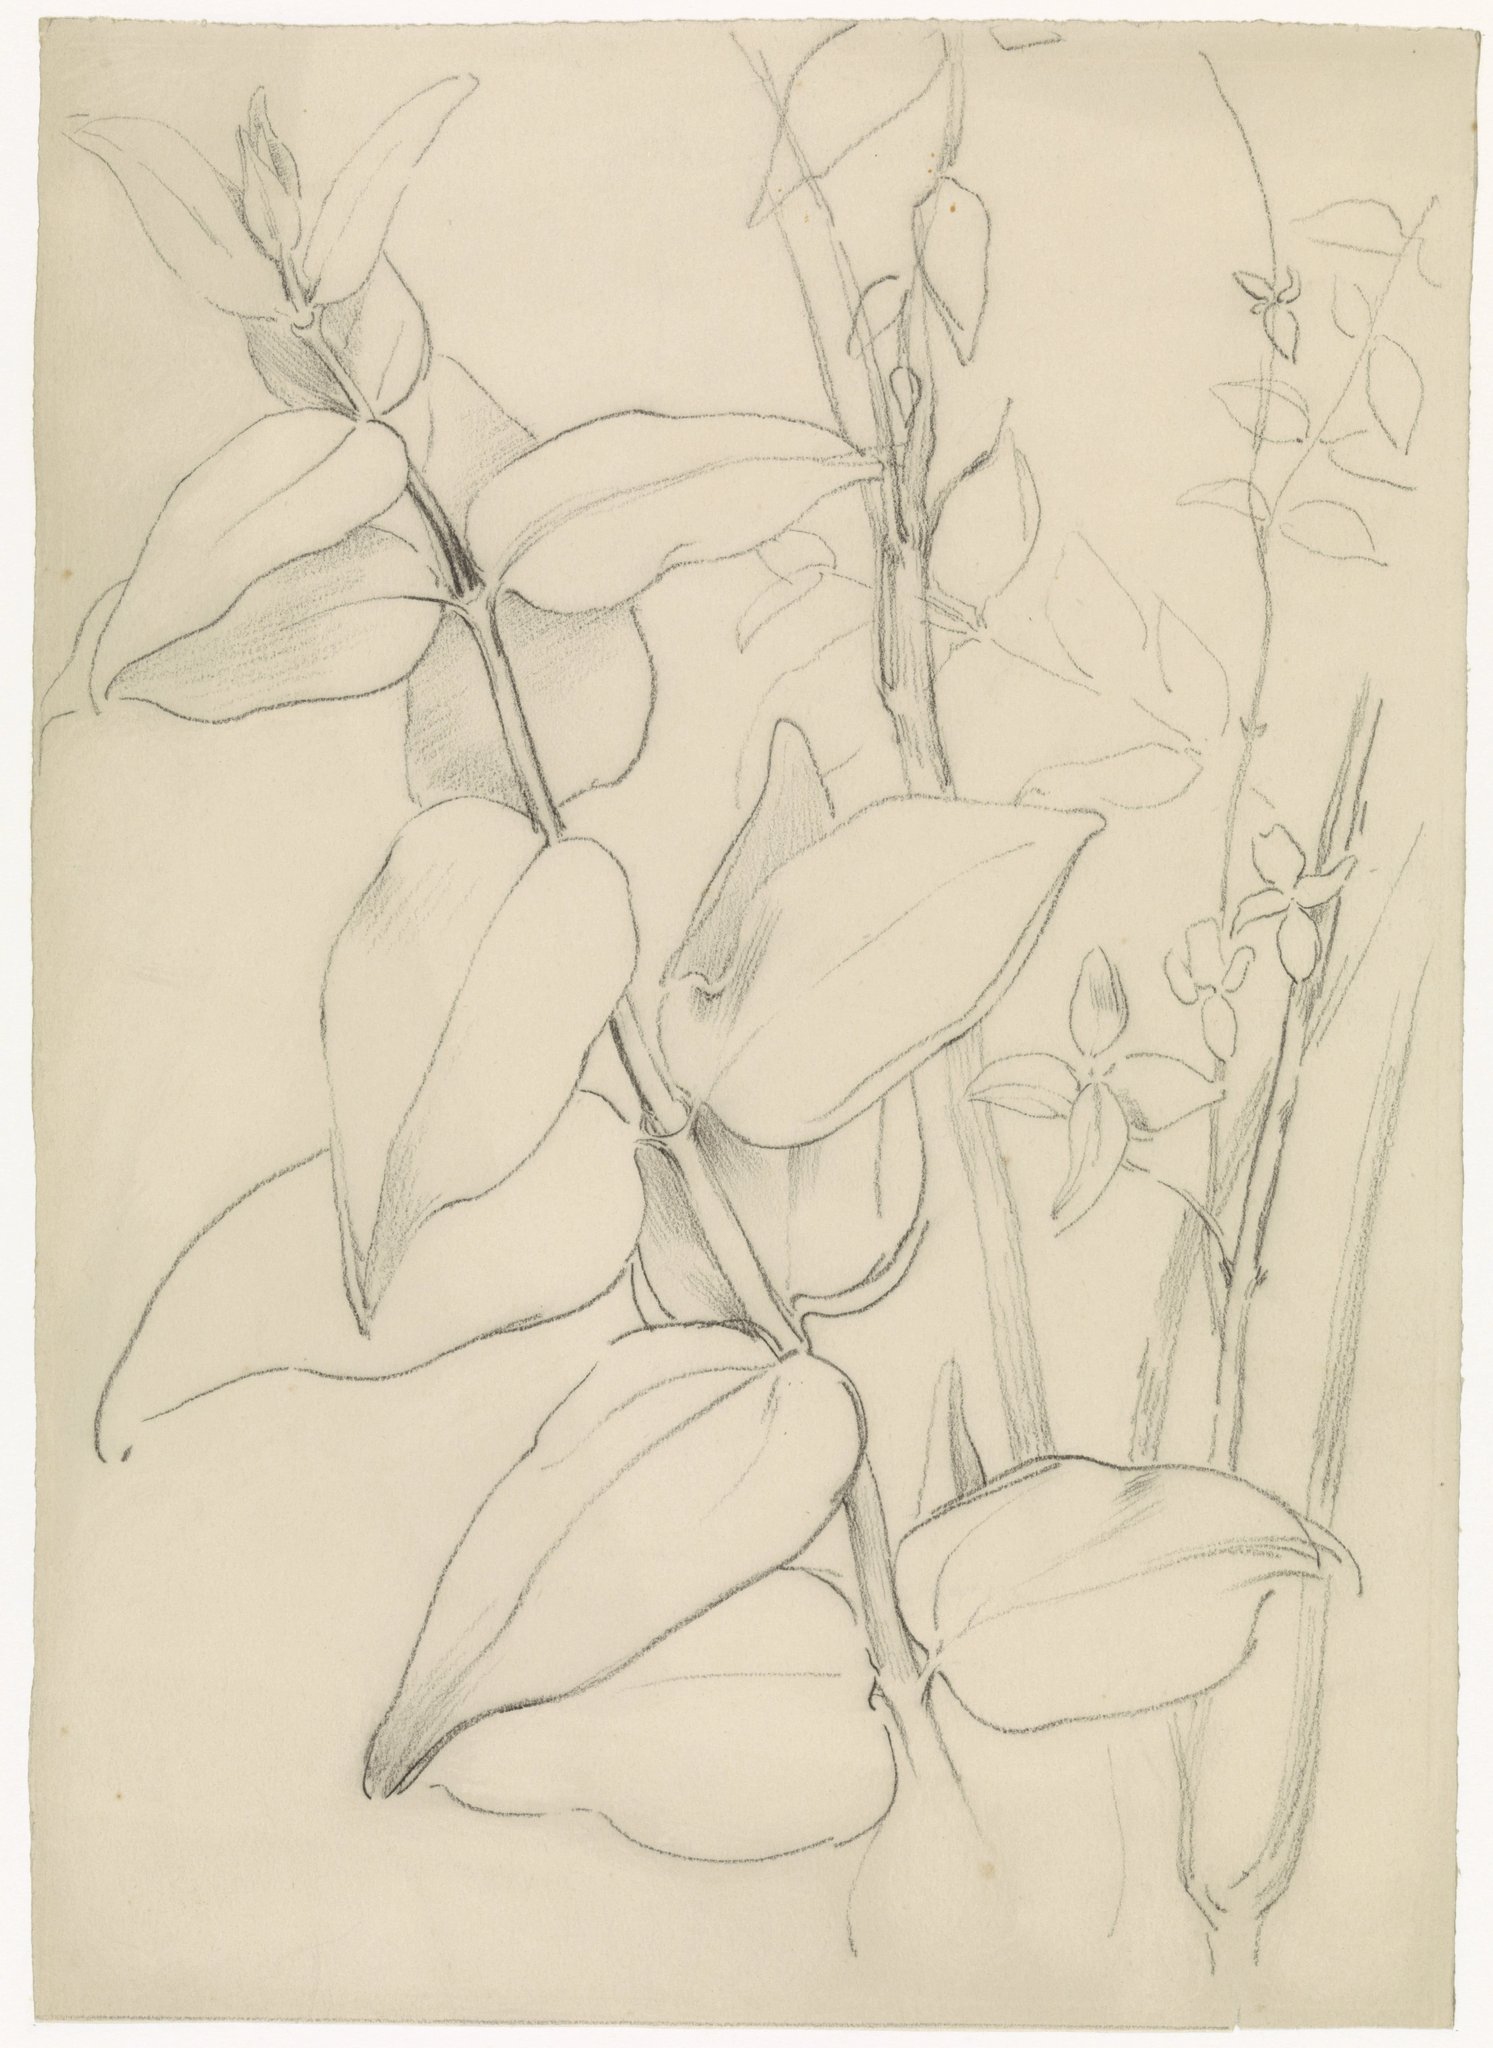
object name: drawing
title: Plantstudie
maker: antoon derkinderen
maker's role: draughtsman, painter, print maker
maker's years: 1859-1925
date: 1869-1925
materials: chalk, paper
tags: flowers